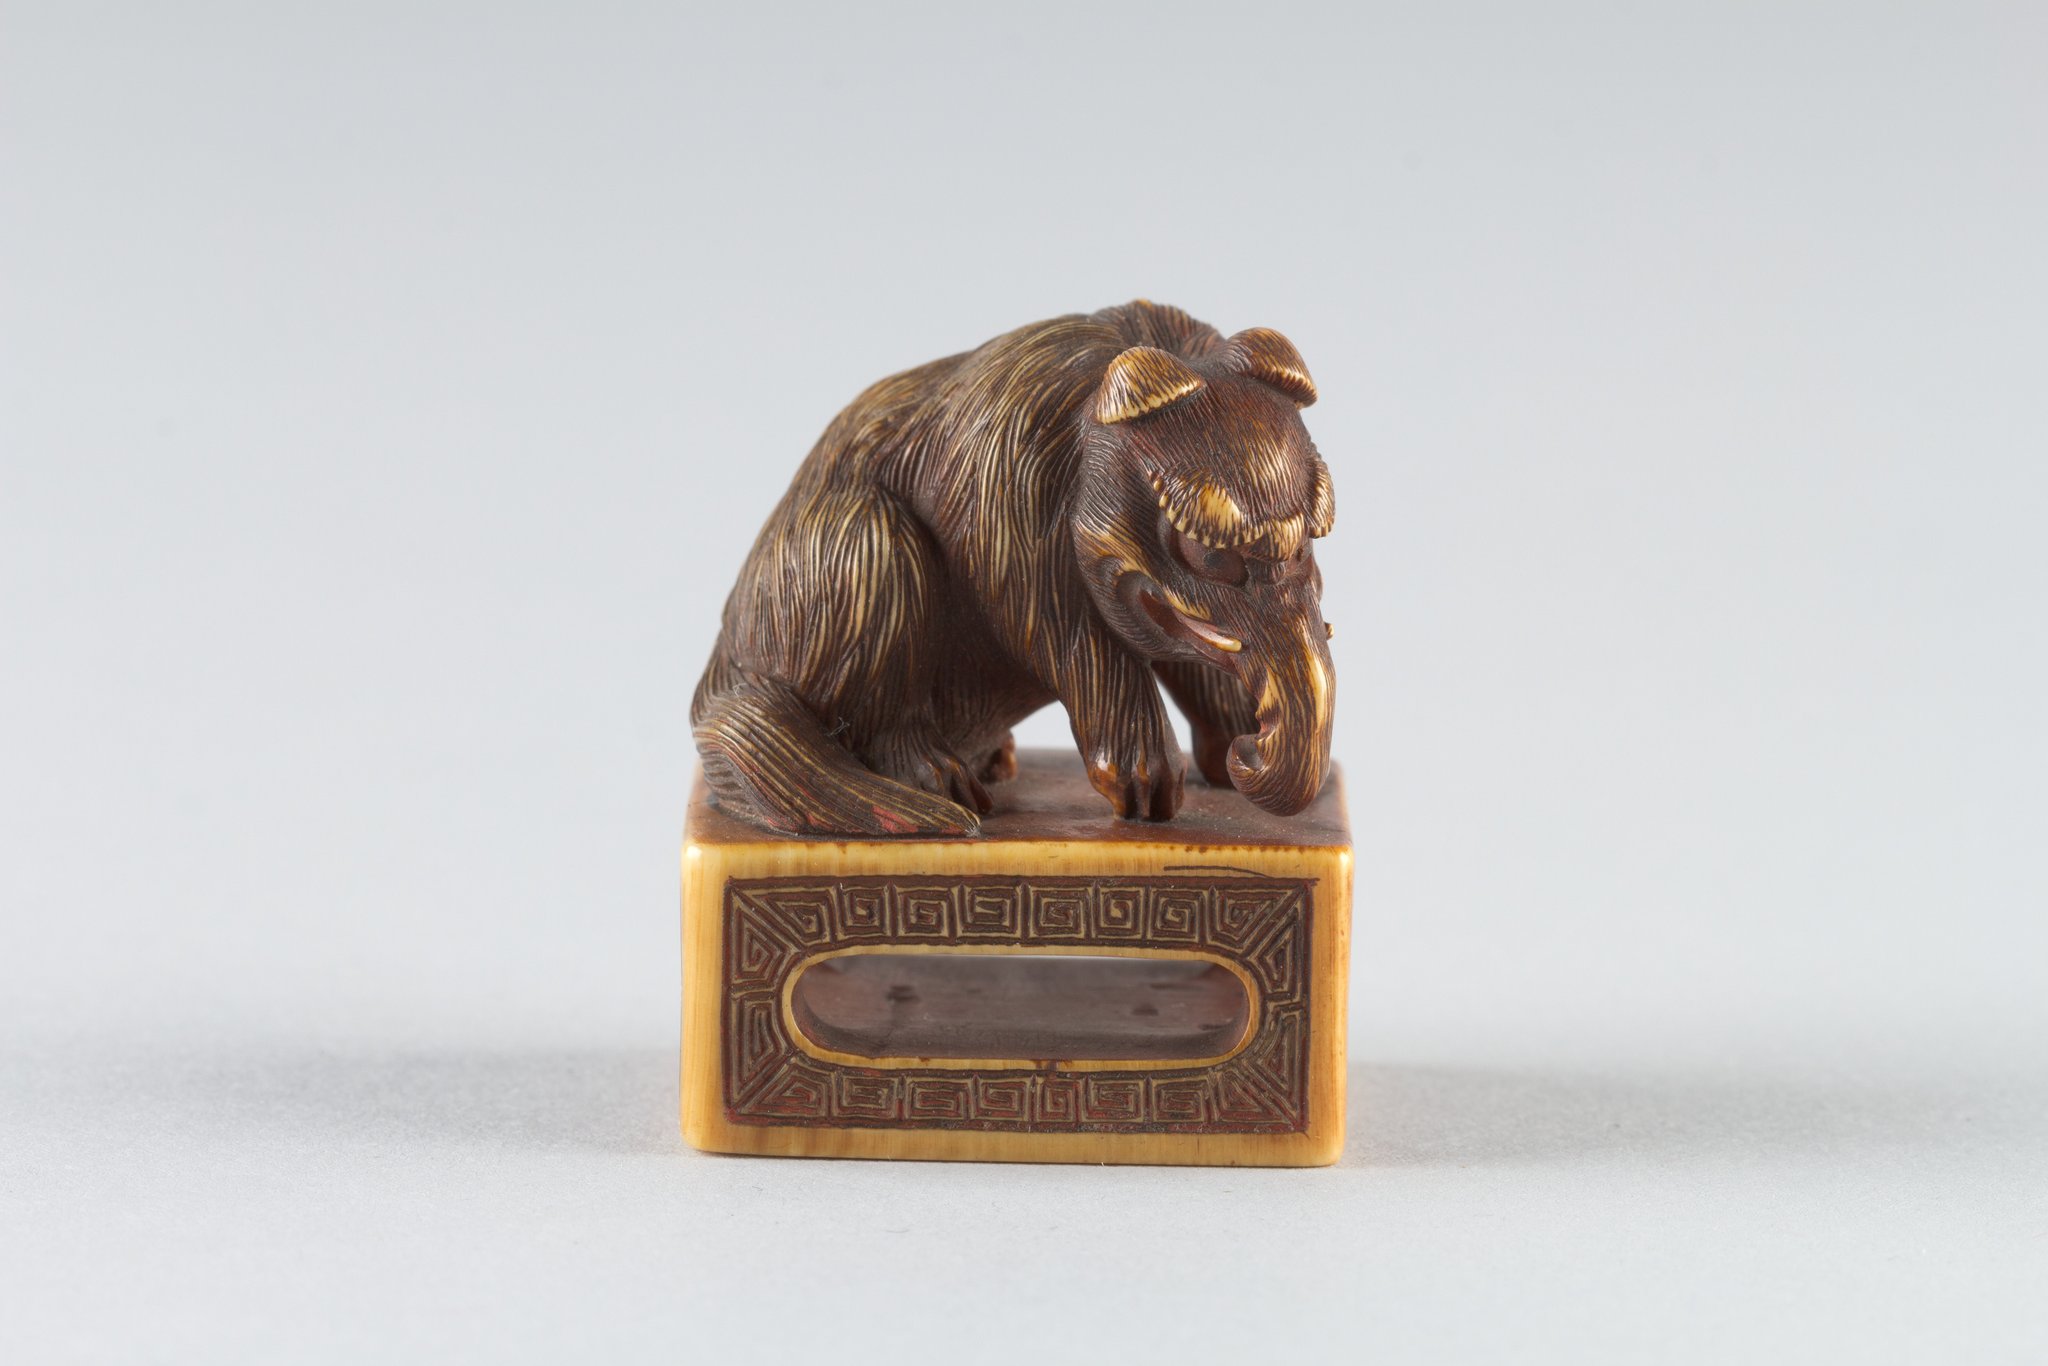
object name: netsuke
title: Netsuke of Elephant on a Seal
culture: japanese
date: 1701-1800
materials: ivory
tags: elephants